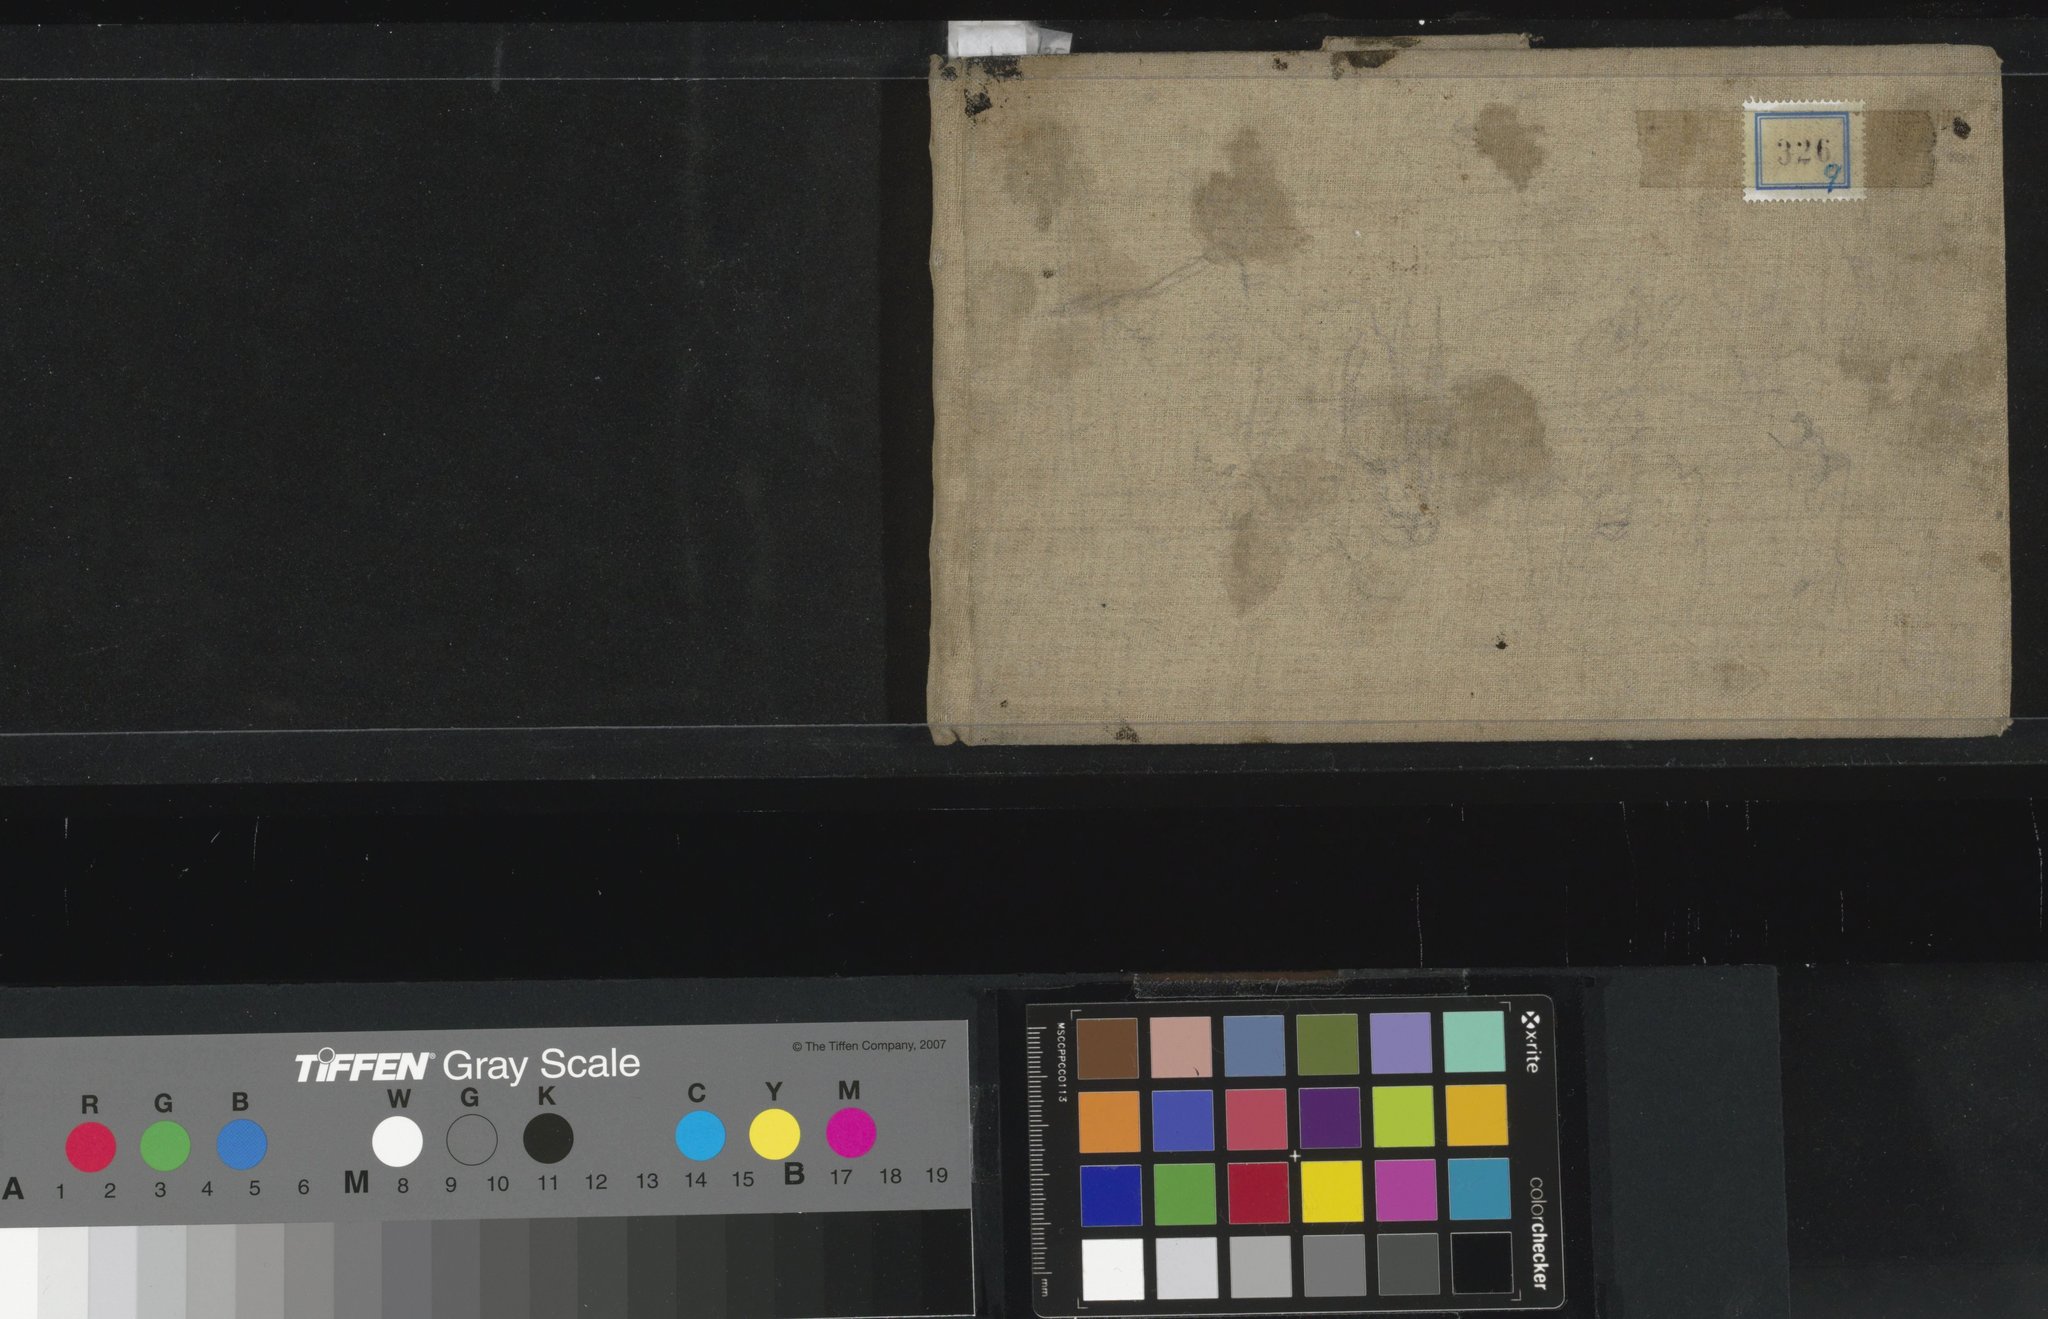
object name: sketchbook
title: Schetsboek met 42 bladen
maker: anton mauve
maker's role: draughtsman, painter, print maker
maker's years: 1838-1888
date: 1848-1888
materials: cardboard, chalk, paint, ink, linen, paper, pencil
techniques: brush, pen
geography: bad godesberg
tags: head (human), landscapes, horse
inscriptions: label: ‘326’, collector's mark: Lugt 2228a, workshop stamp: ‘Atelier/ A Mauve.’, retailer's mark: ‘Zei/ von/ A. HENRY/ BONN’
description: Schetsboek bestaande uit 42 bladen met voornamelijk landschappen, bomen, (trek)paarden, ezels en figuurstudies, waaronder croquet spelende vrouwen. Tevens een gezicht op Bad Godesberg aan de Rijn. Op de voor- en achterzijde van de boekband potloodschetsen van figuren en koppen.